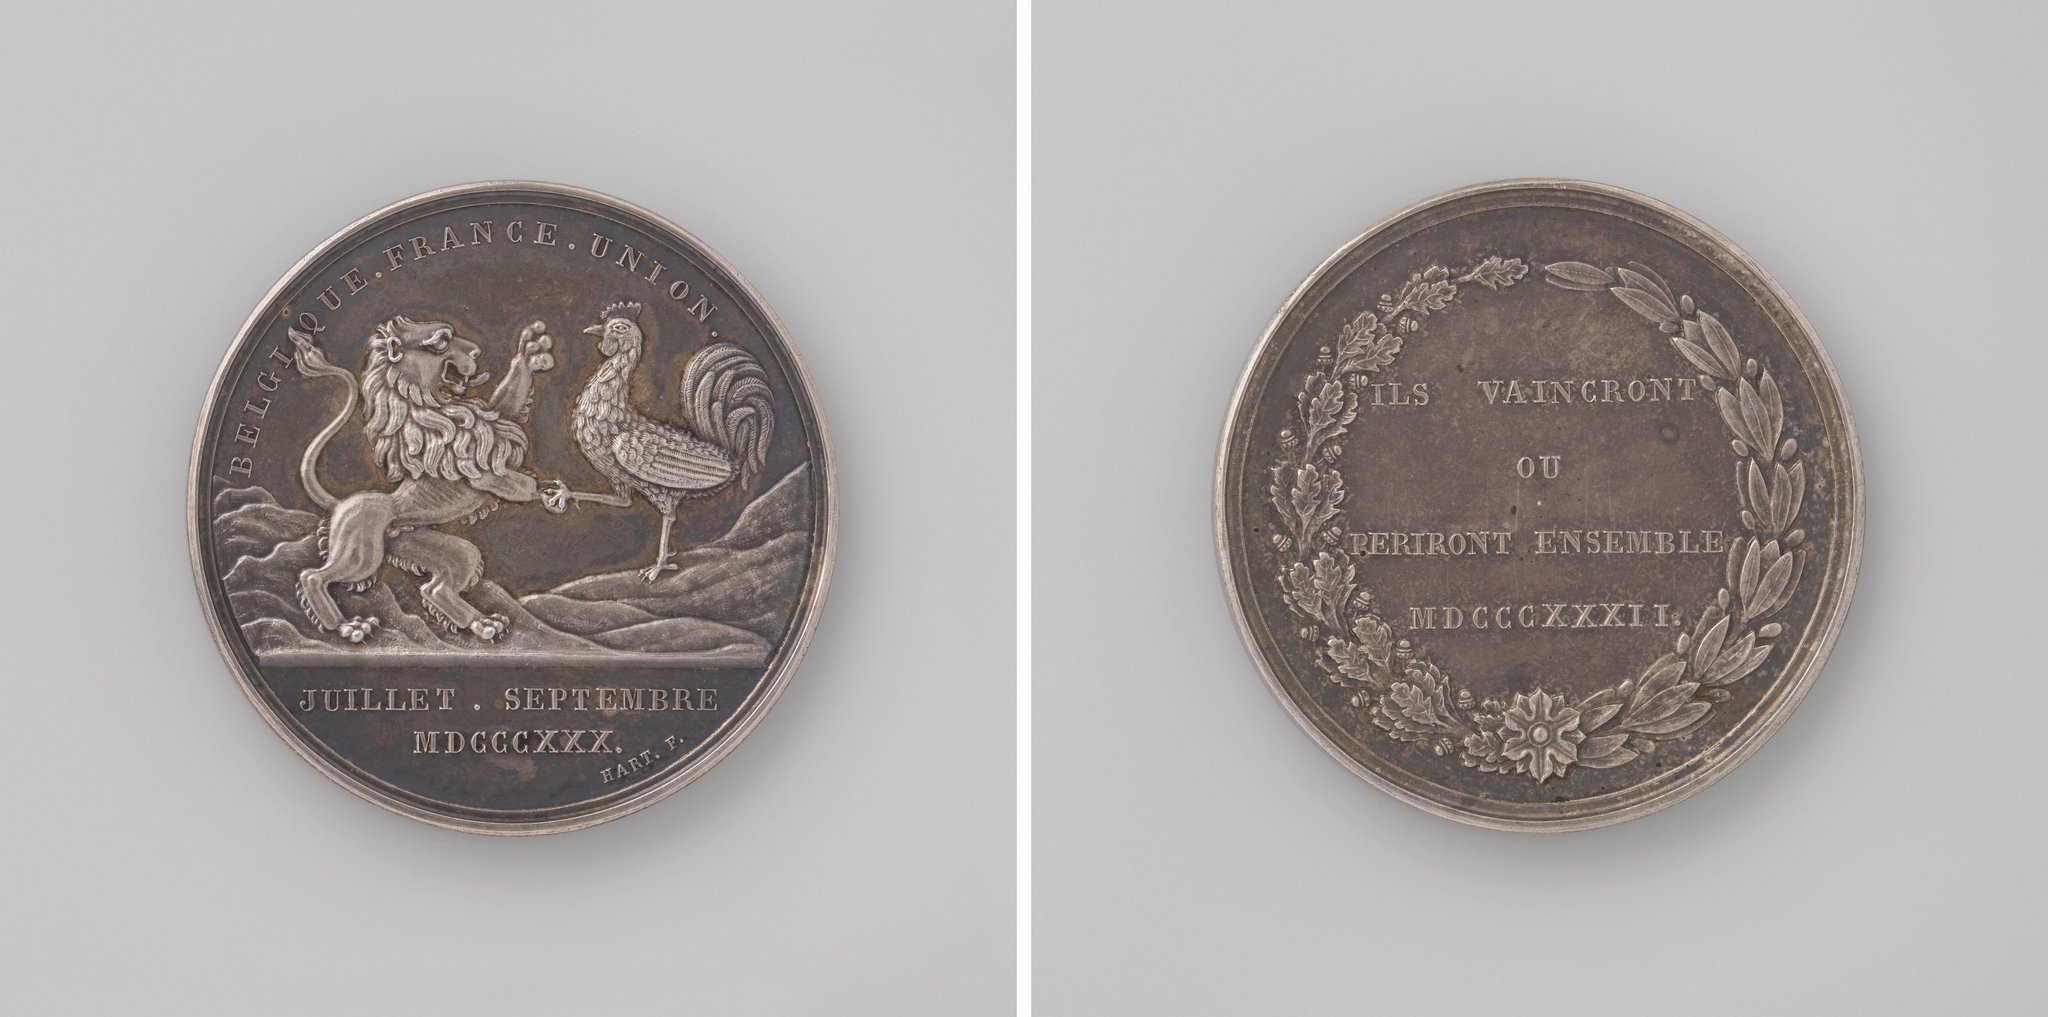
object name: history medal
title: Franse steun bij de verovering van de citadel van Antwerpen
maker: laurent joseph hart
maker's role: die cutter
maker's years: 1810-1860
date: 1832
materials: silver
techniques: striking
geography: brussels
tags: citadel van antwerpen (19e eeuw), strijd om de citadel van antwerpen (1832), belgische revolutie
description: Zilveren penning. Voorzijde: Franse haan en Belgische leeuw geven elkaar poot binnen omschrift; afsnede: opschrift. Keerzijde: opschrift in tot krans samengebonden eiken- en olijftak.